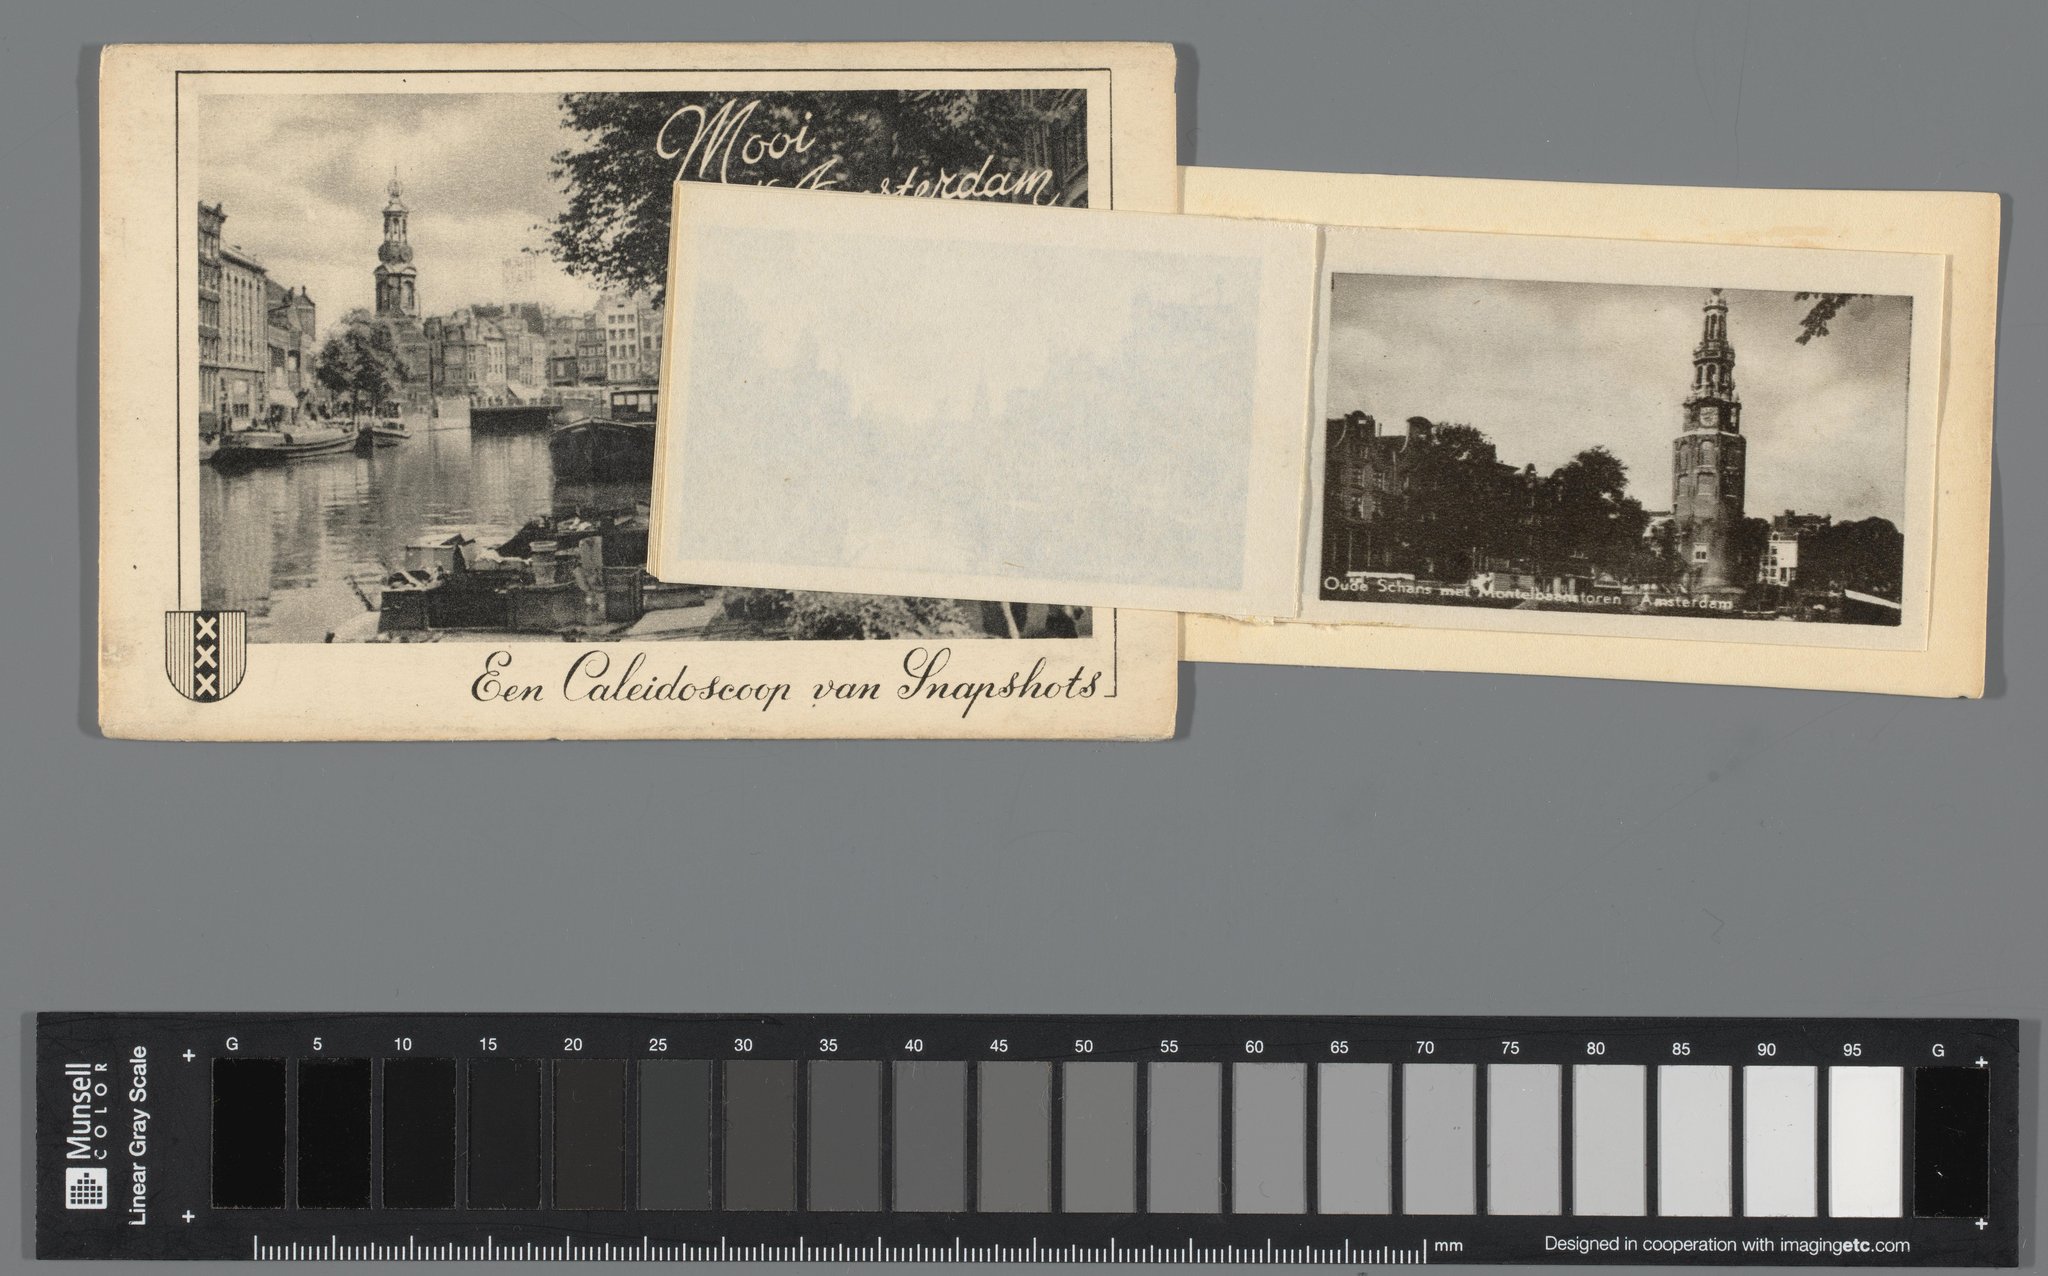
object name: photomechanical print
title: Gezicht op de Montelbaanstoren aan de Schans in Amsterdam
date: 1920-1950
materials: paper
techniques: rotogravure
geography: eemnes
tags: tower, clock tower ~ monumental adornment, canals, waters (in city)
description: Deze prent maakt deel uit van een omslag met tien prenten.